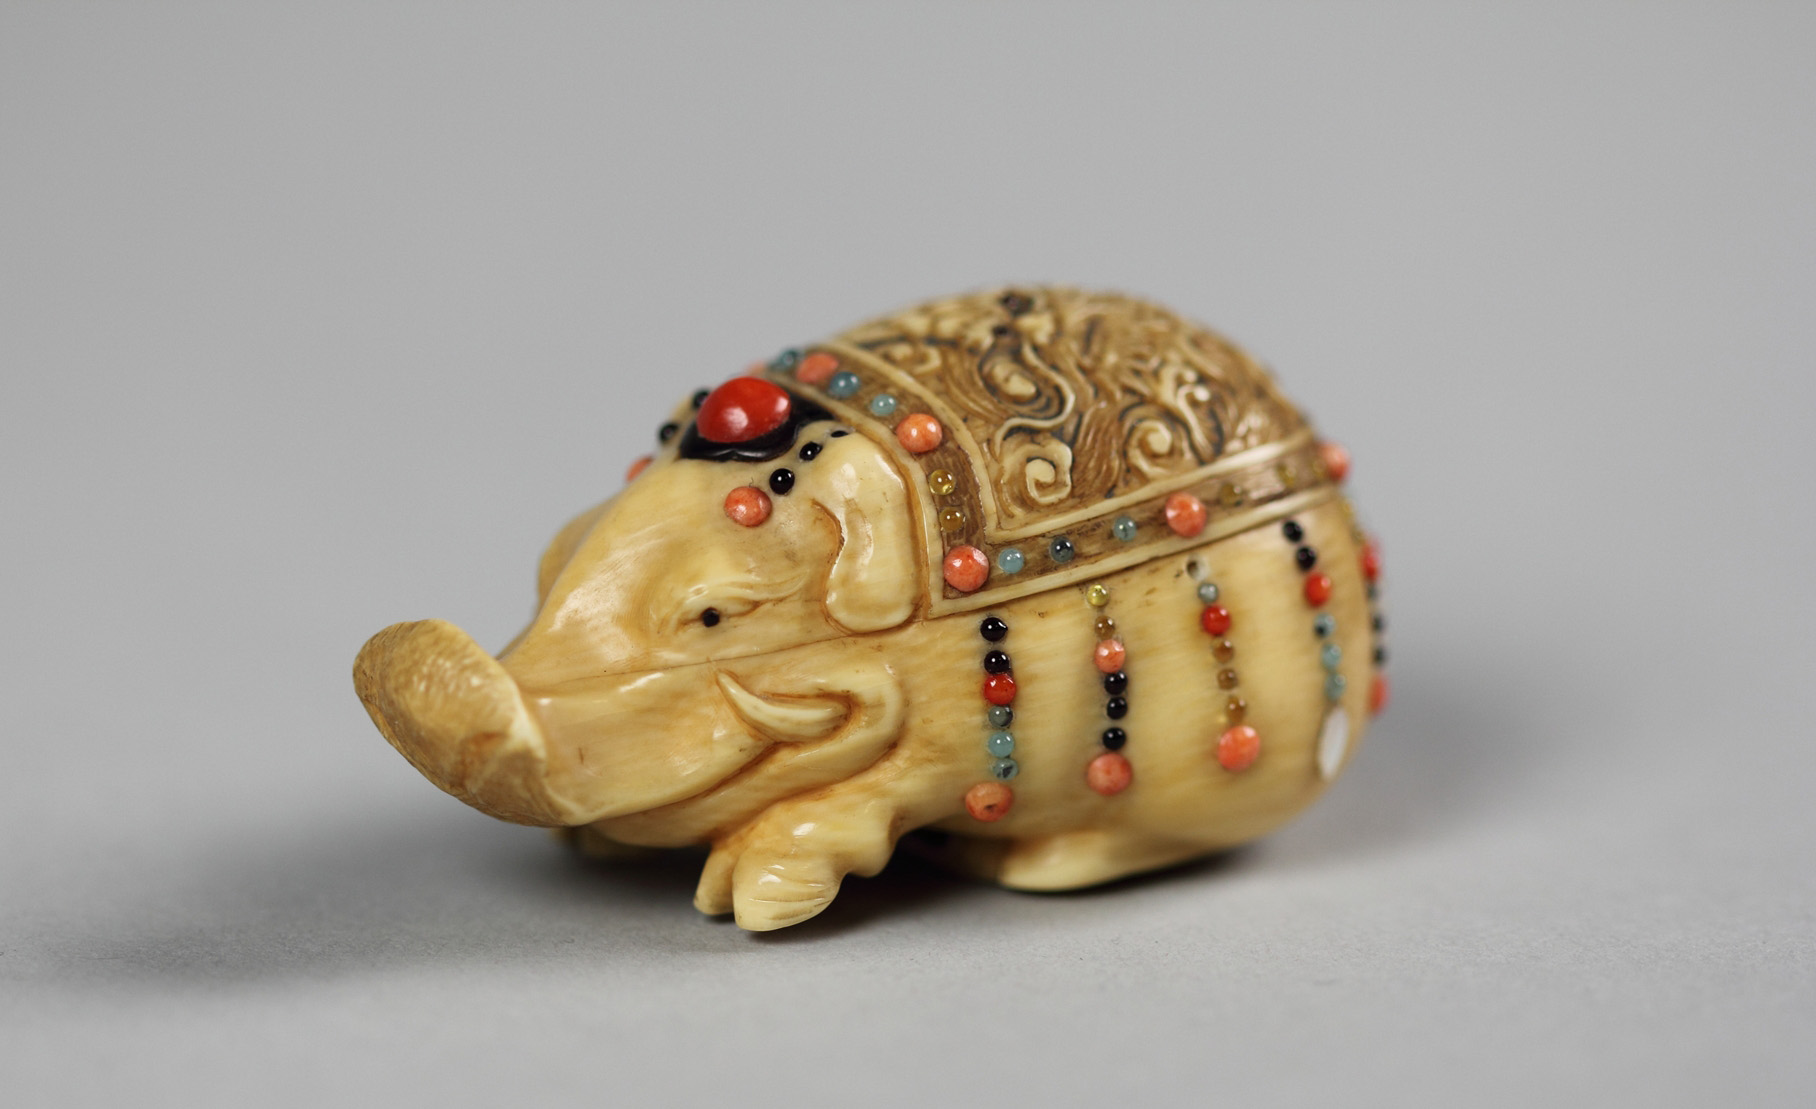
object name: netsuke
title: Boar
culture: japanese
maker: kōhōsai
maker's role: artist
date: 1801-1900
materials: coral, ivory, stone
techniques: inlay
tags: boars